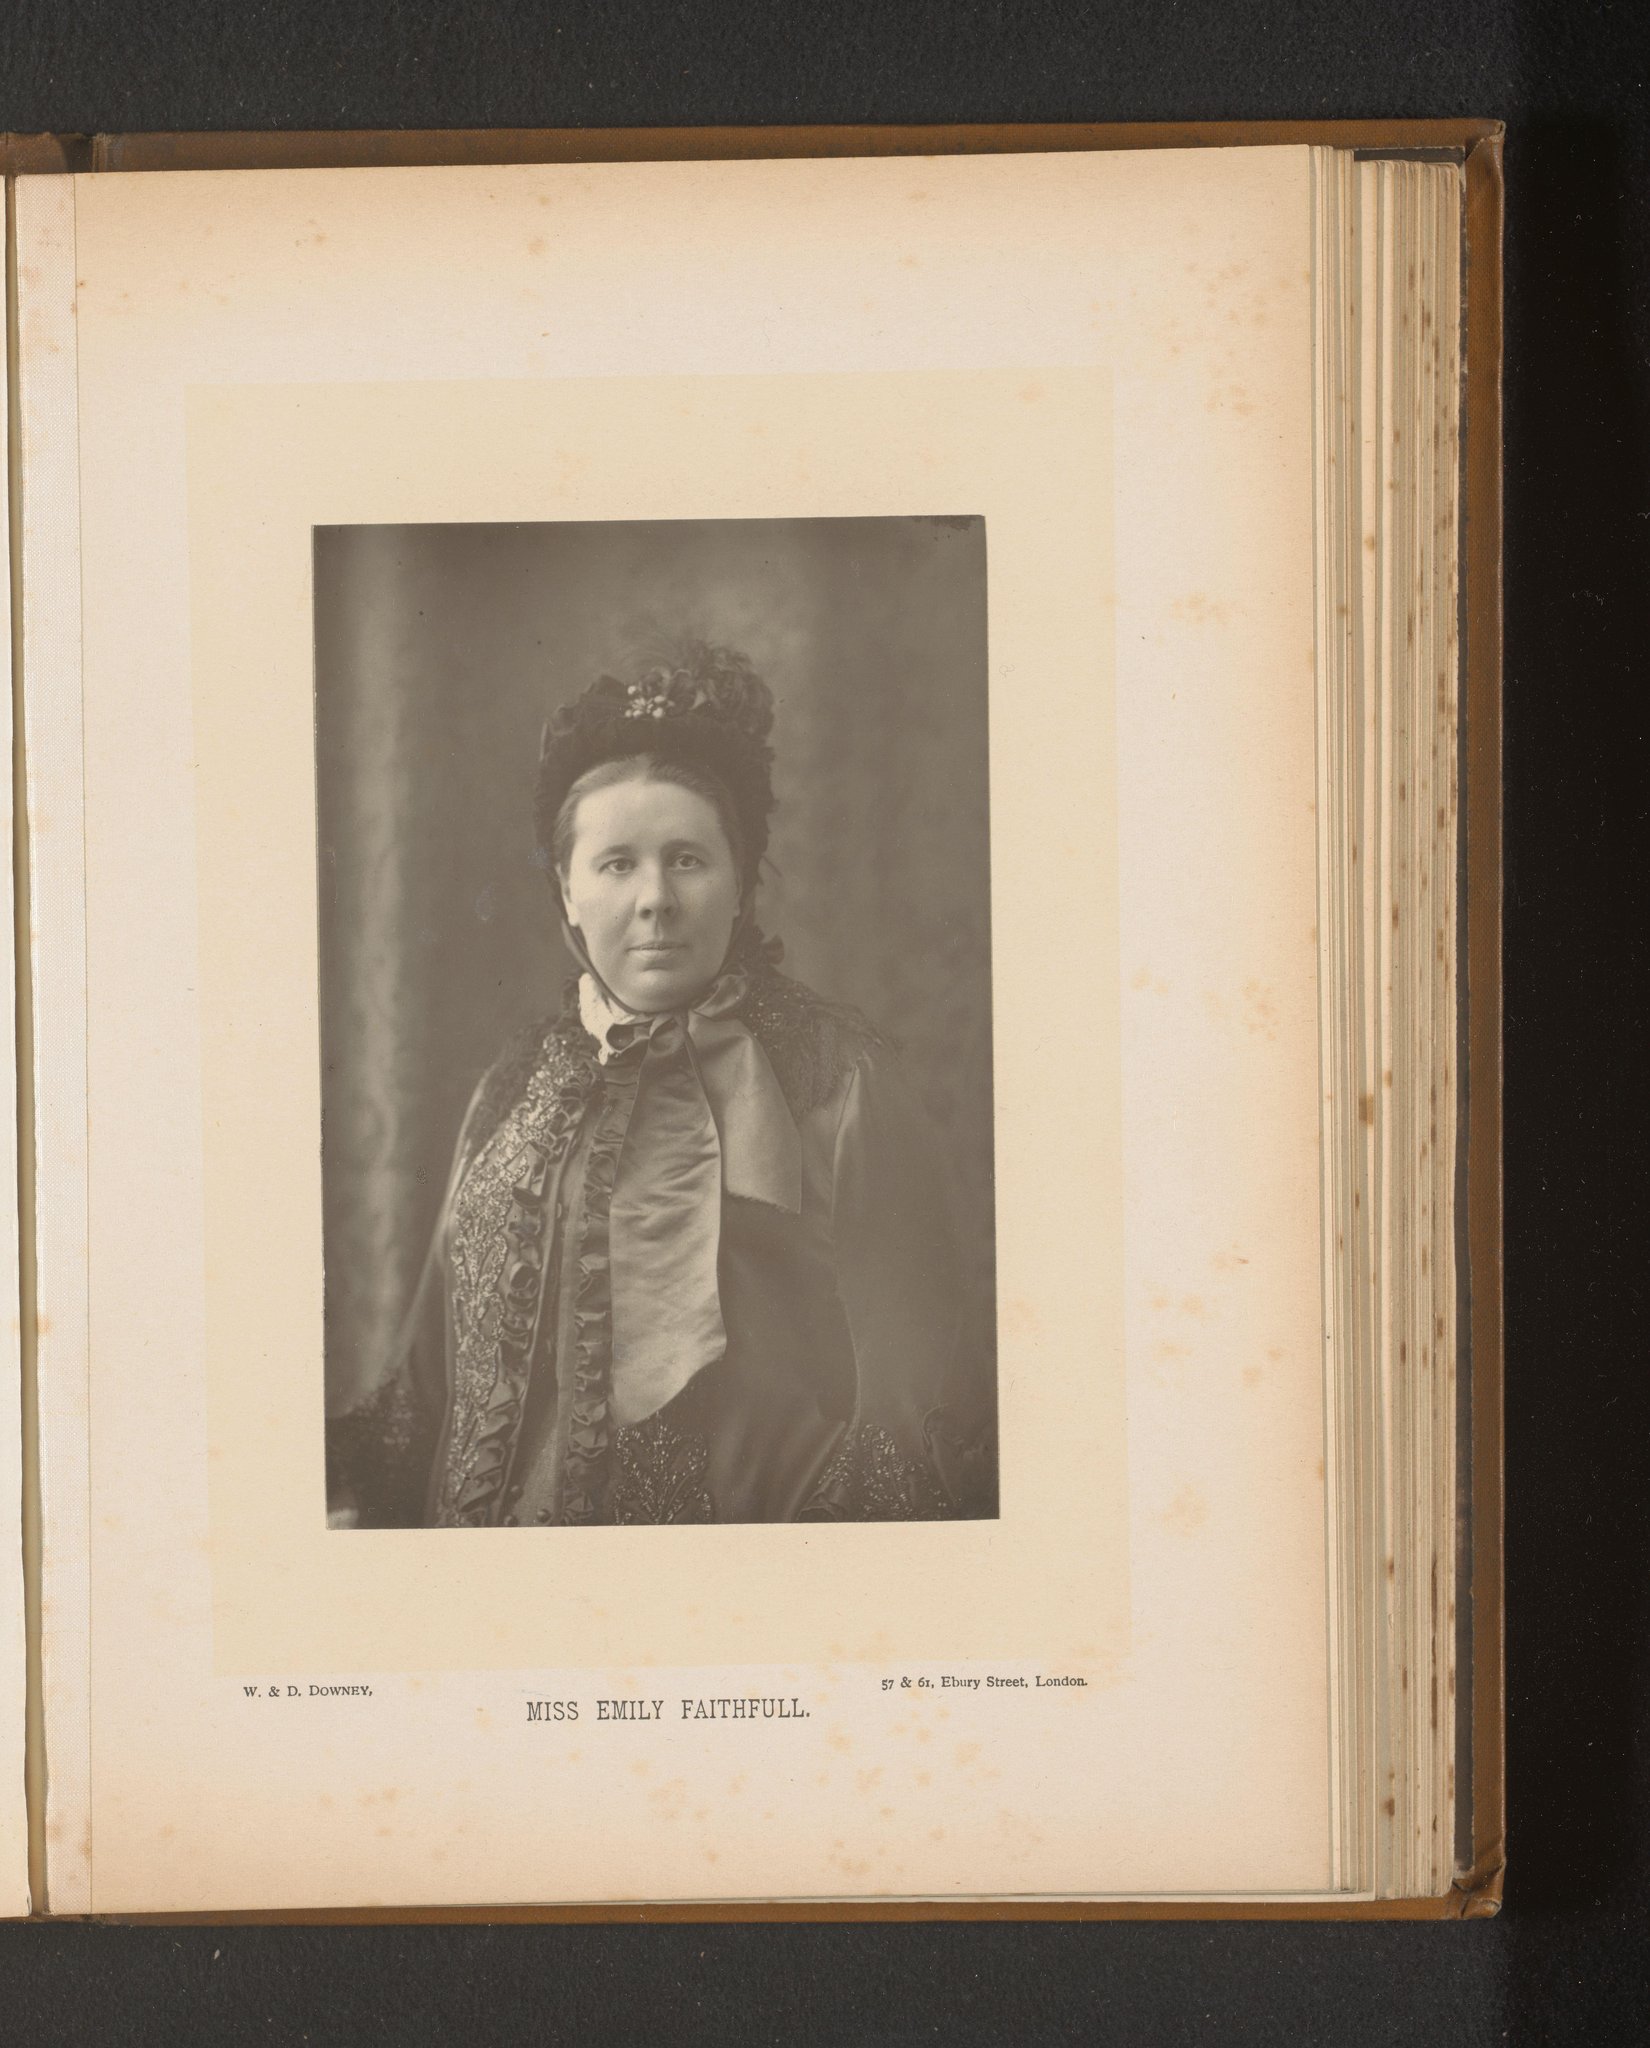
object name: page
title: Miss Emily Faithfull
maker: Anonymous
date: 1881-1891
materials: paper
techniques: woodburytype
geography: london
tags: political enfranchisement of women, women's liberation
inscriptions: inscription: ‘57 & 61, Elbury Street, London.’